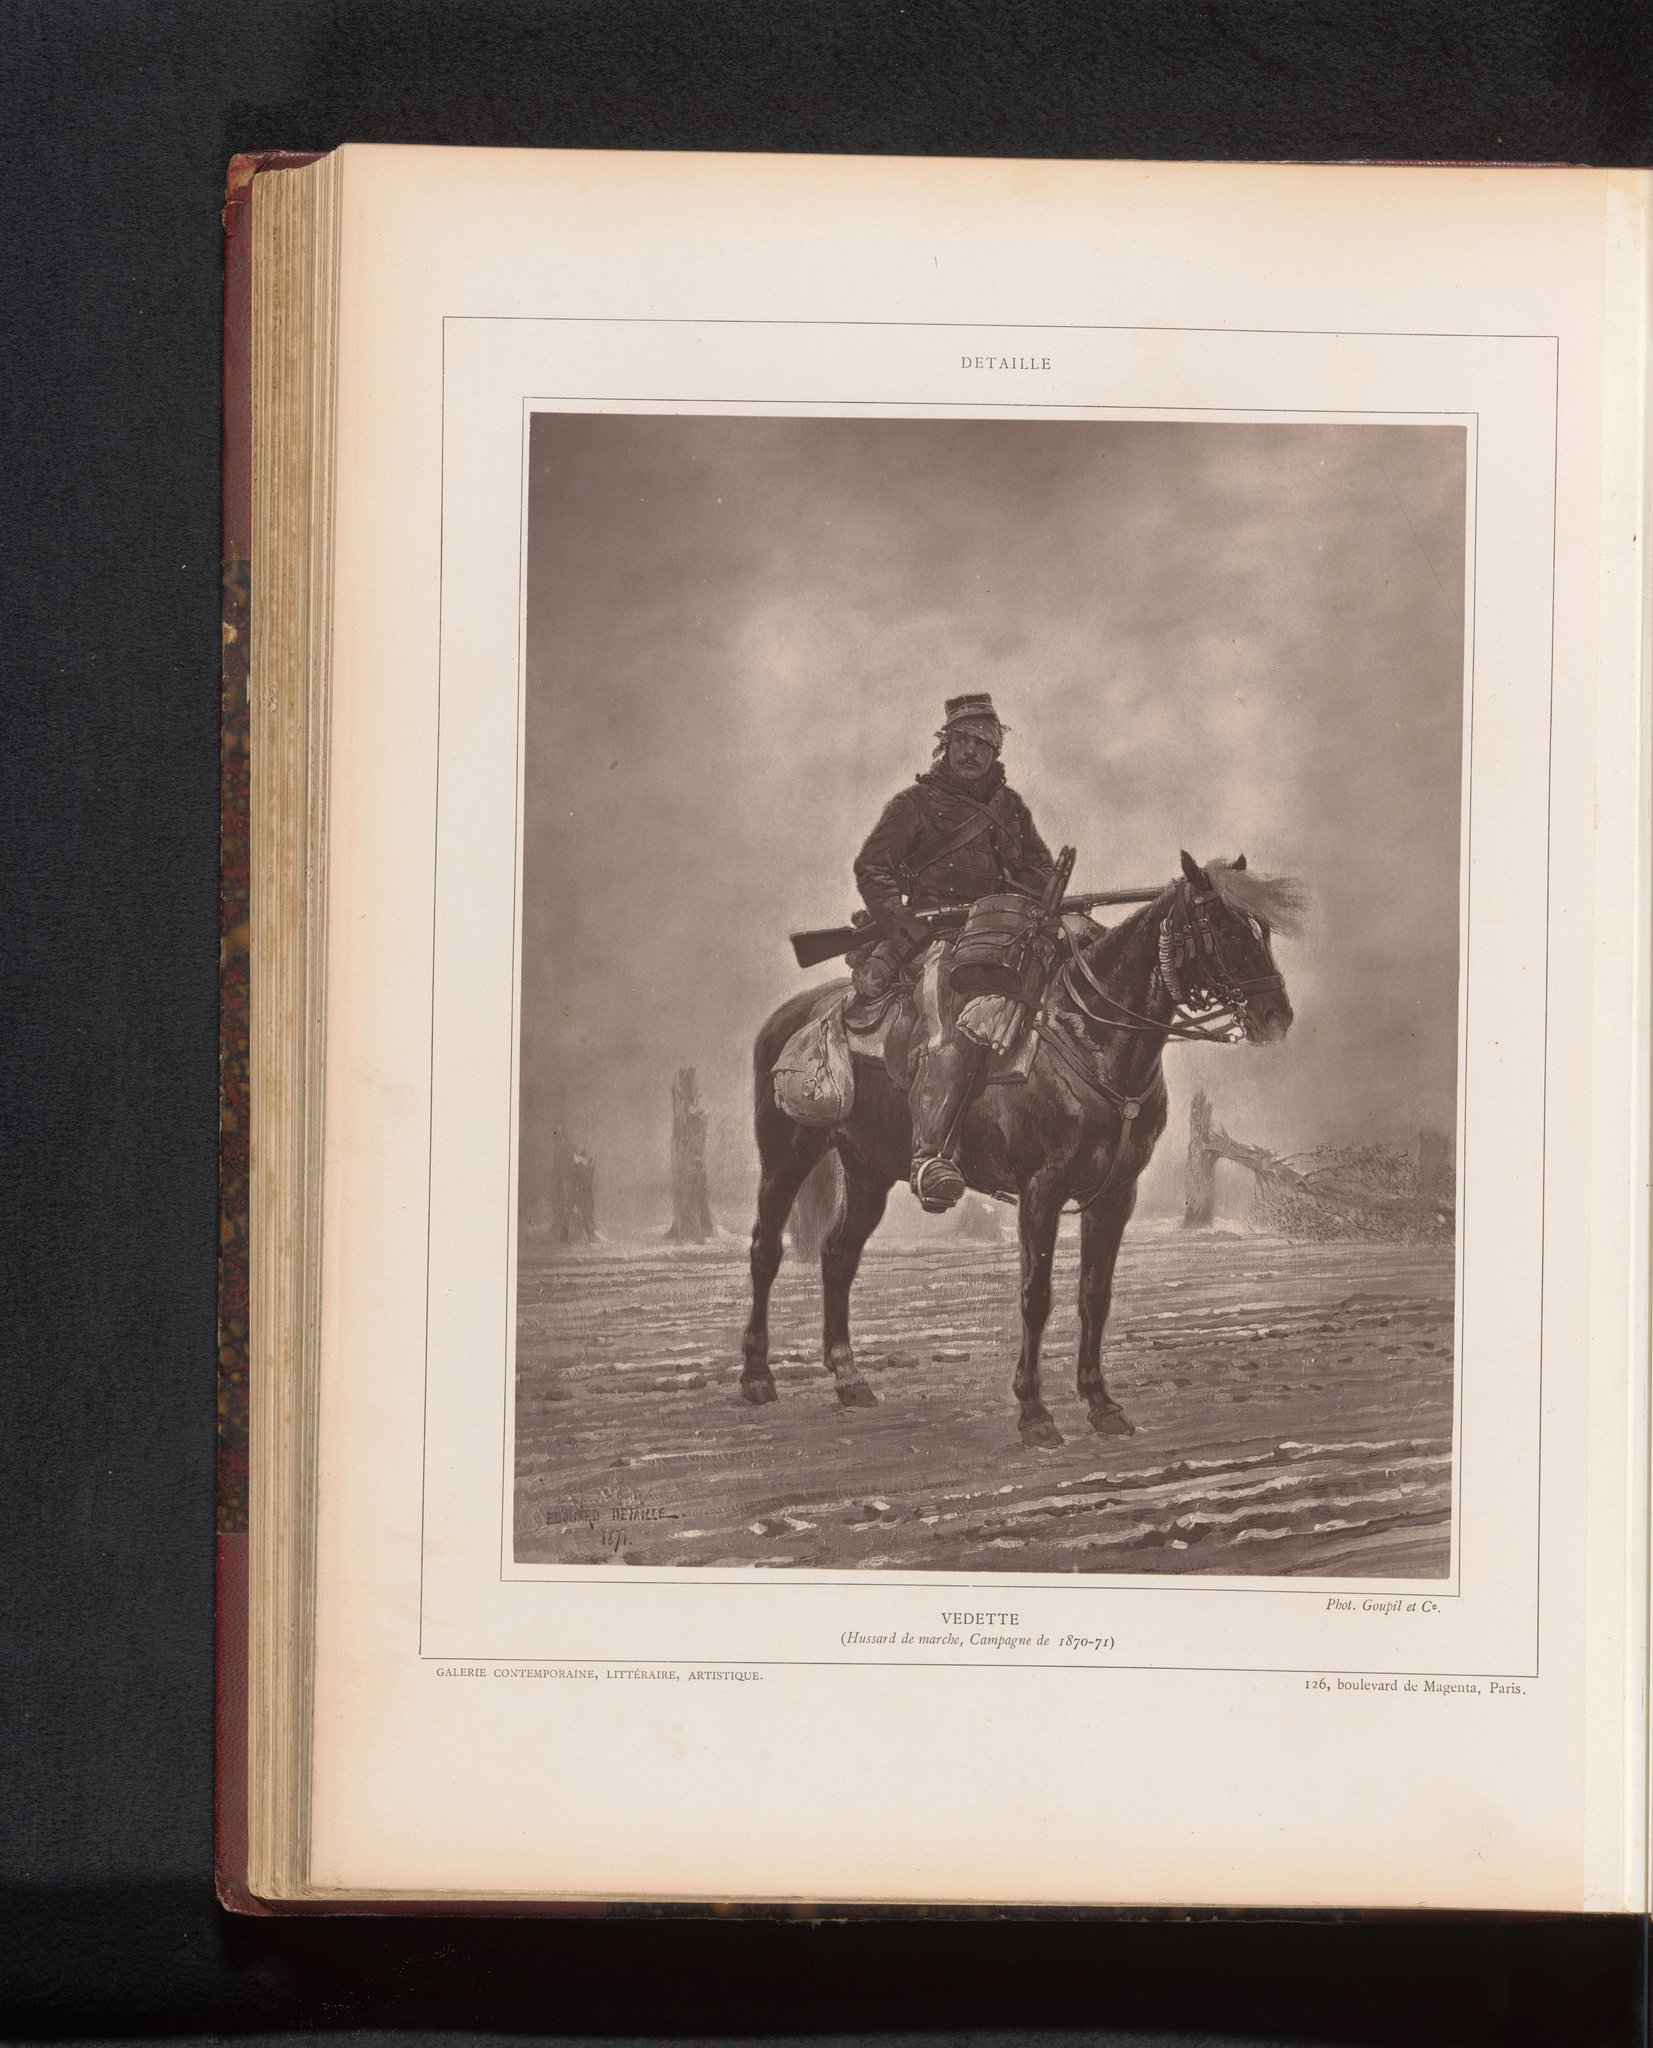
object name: photomechanical print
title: Reproductie van Vedette door Édouard Detaille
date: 1872-1877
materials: paper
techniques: woodburytype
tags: riding a horse, ass, or mule; rider, horseman, the soldier; the soldier's life, painting, drawing and the graphic arts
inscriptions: inscription: ‘Galerie Contemporaine, Littéraire, Artistique/ 126, boulevard de Magenta, Paris’